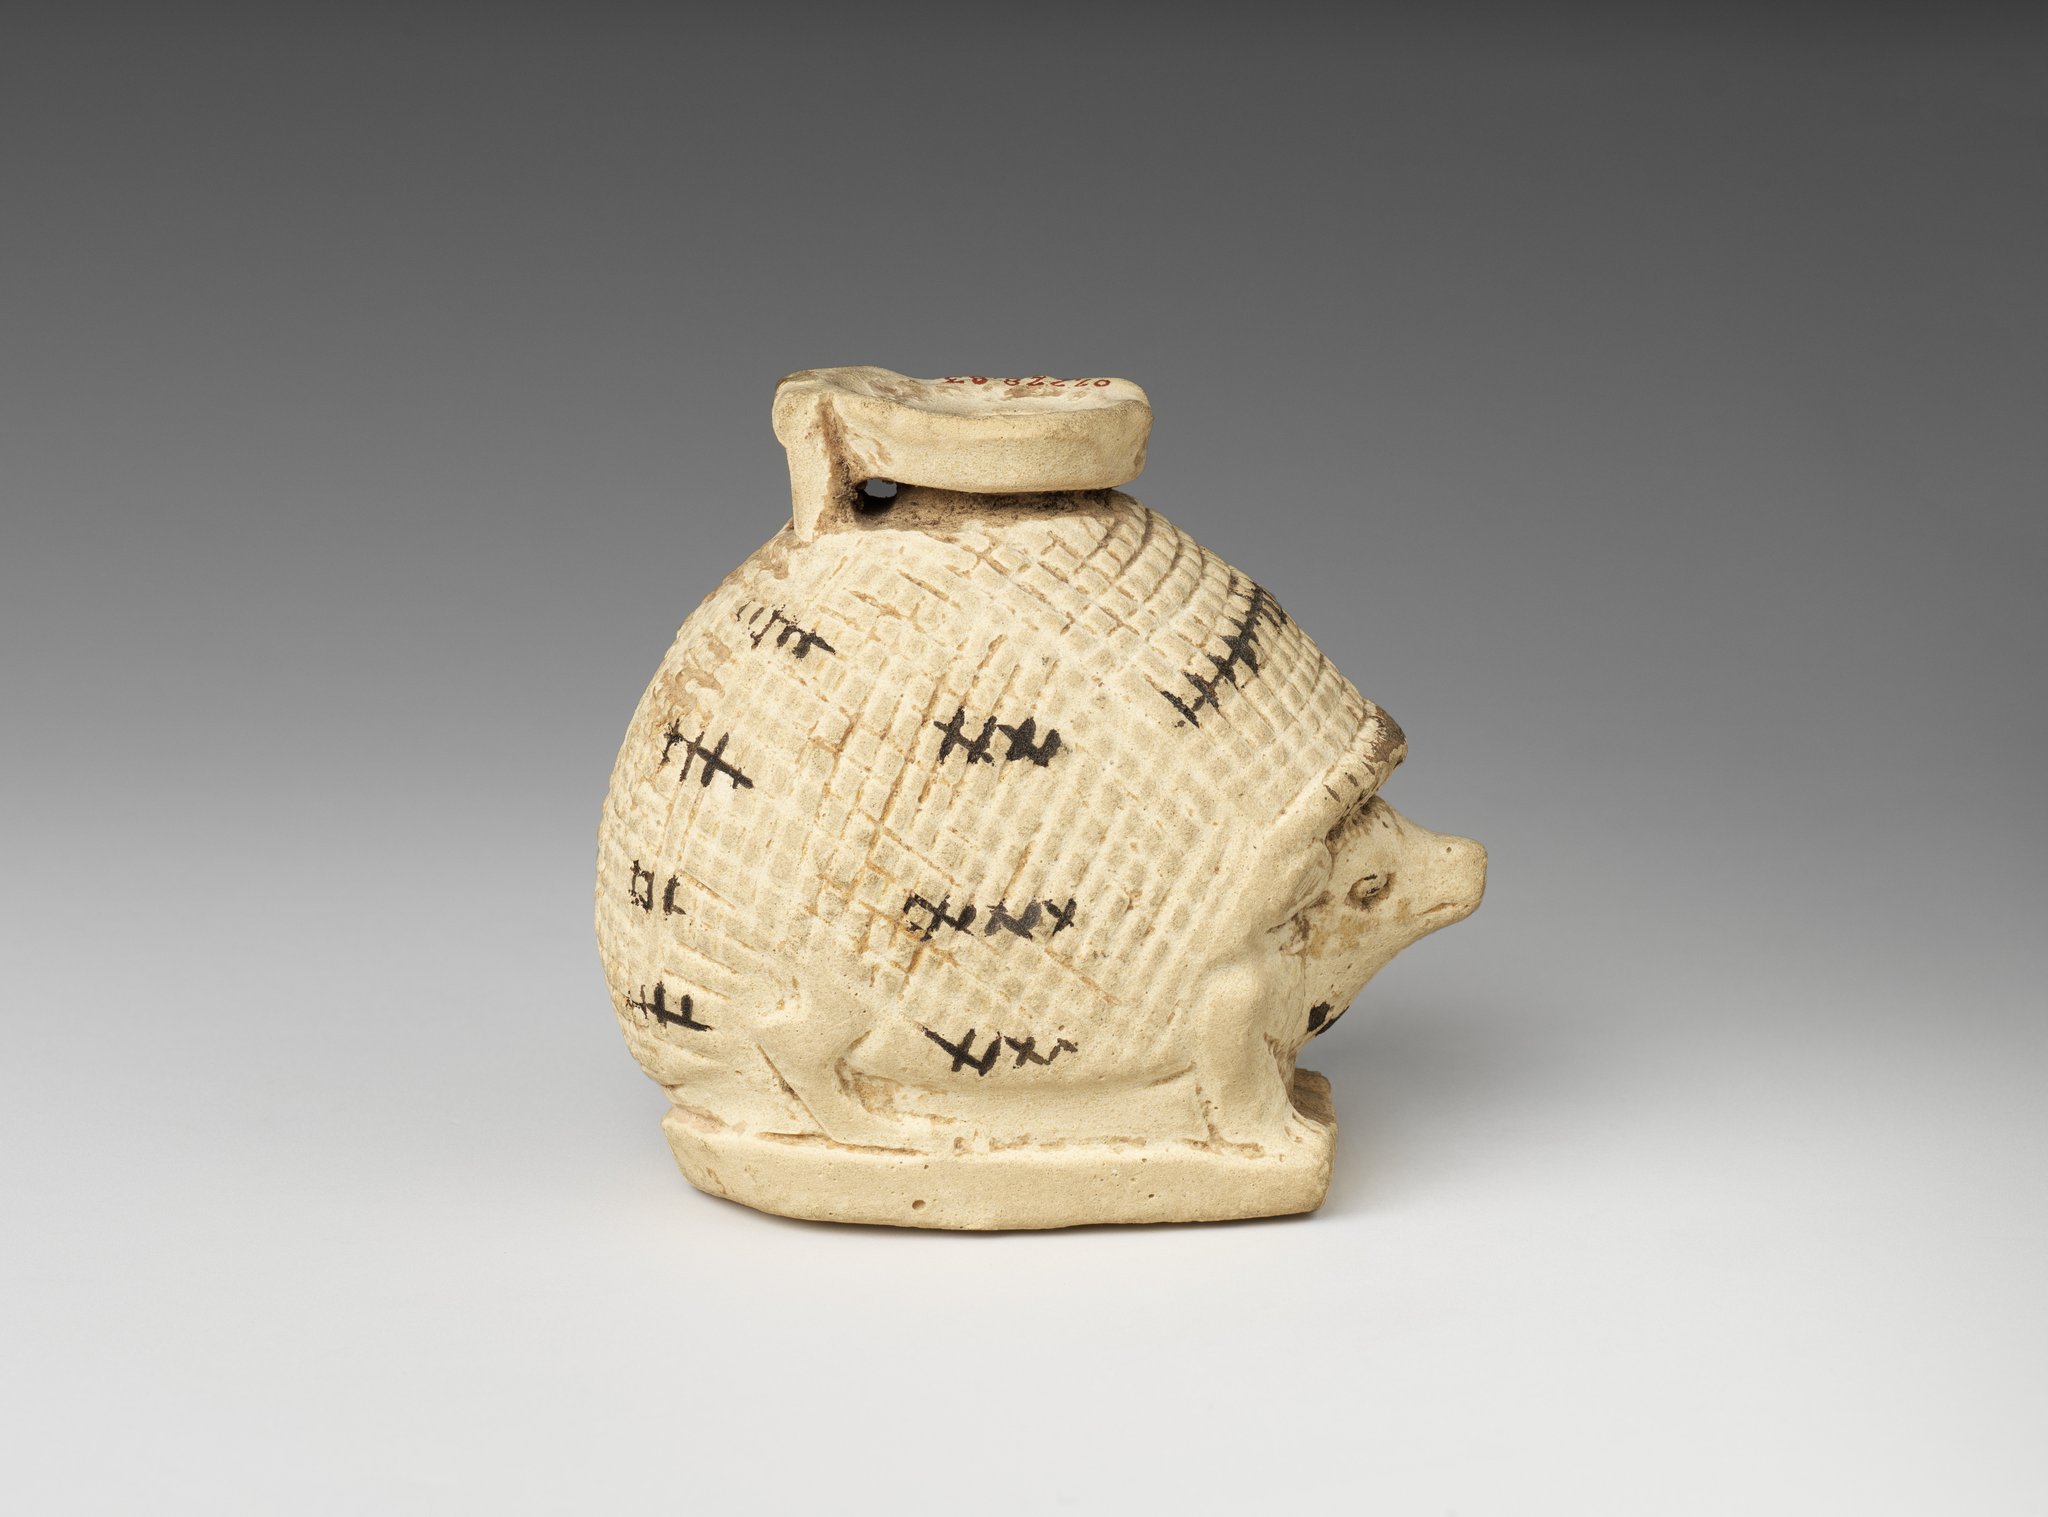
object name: jar, hedgehog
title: Aryballos (perfume jar) in the form of hedgehog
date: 600-501 BCE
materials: faience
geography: egypt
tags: hedgehogs